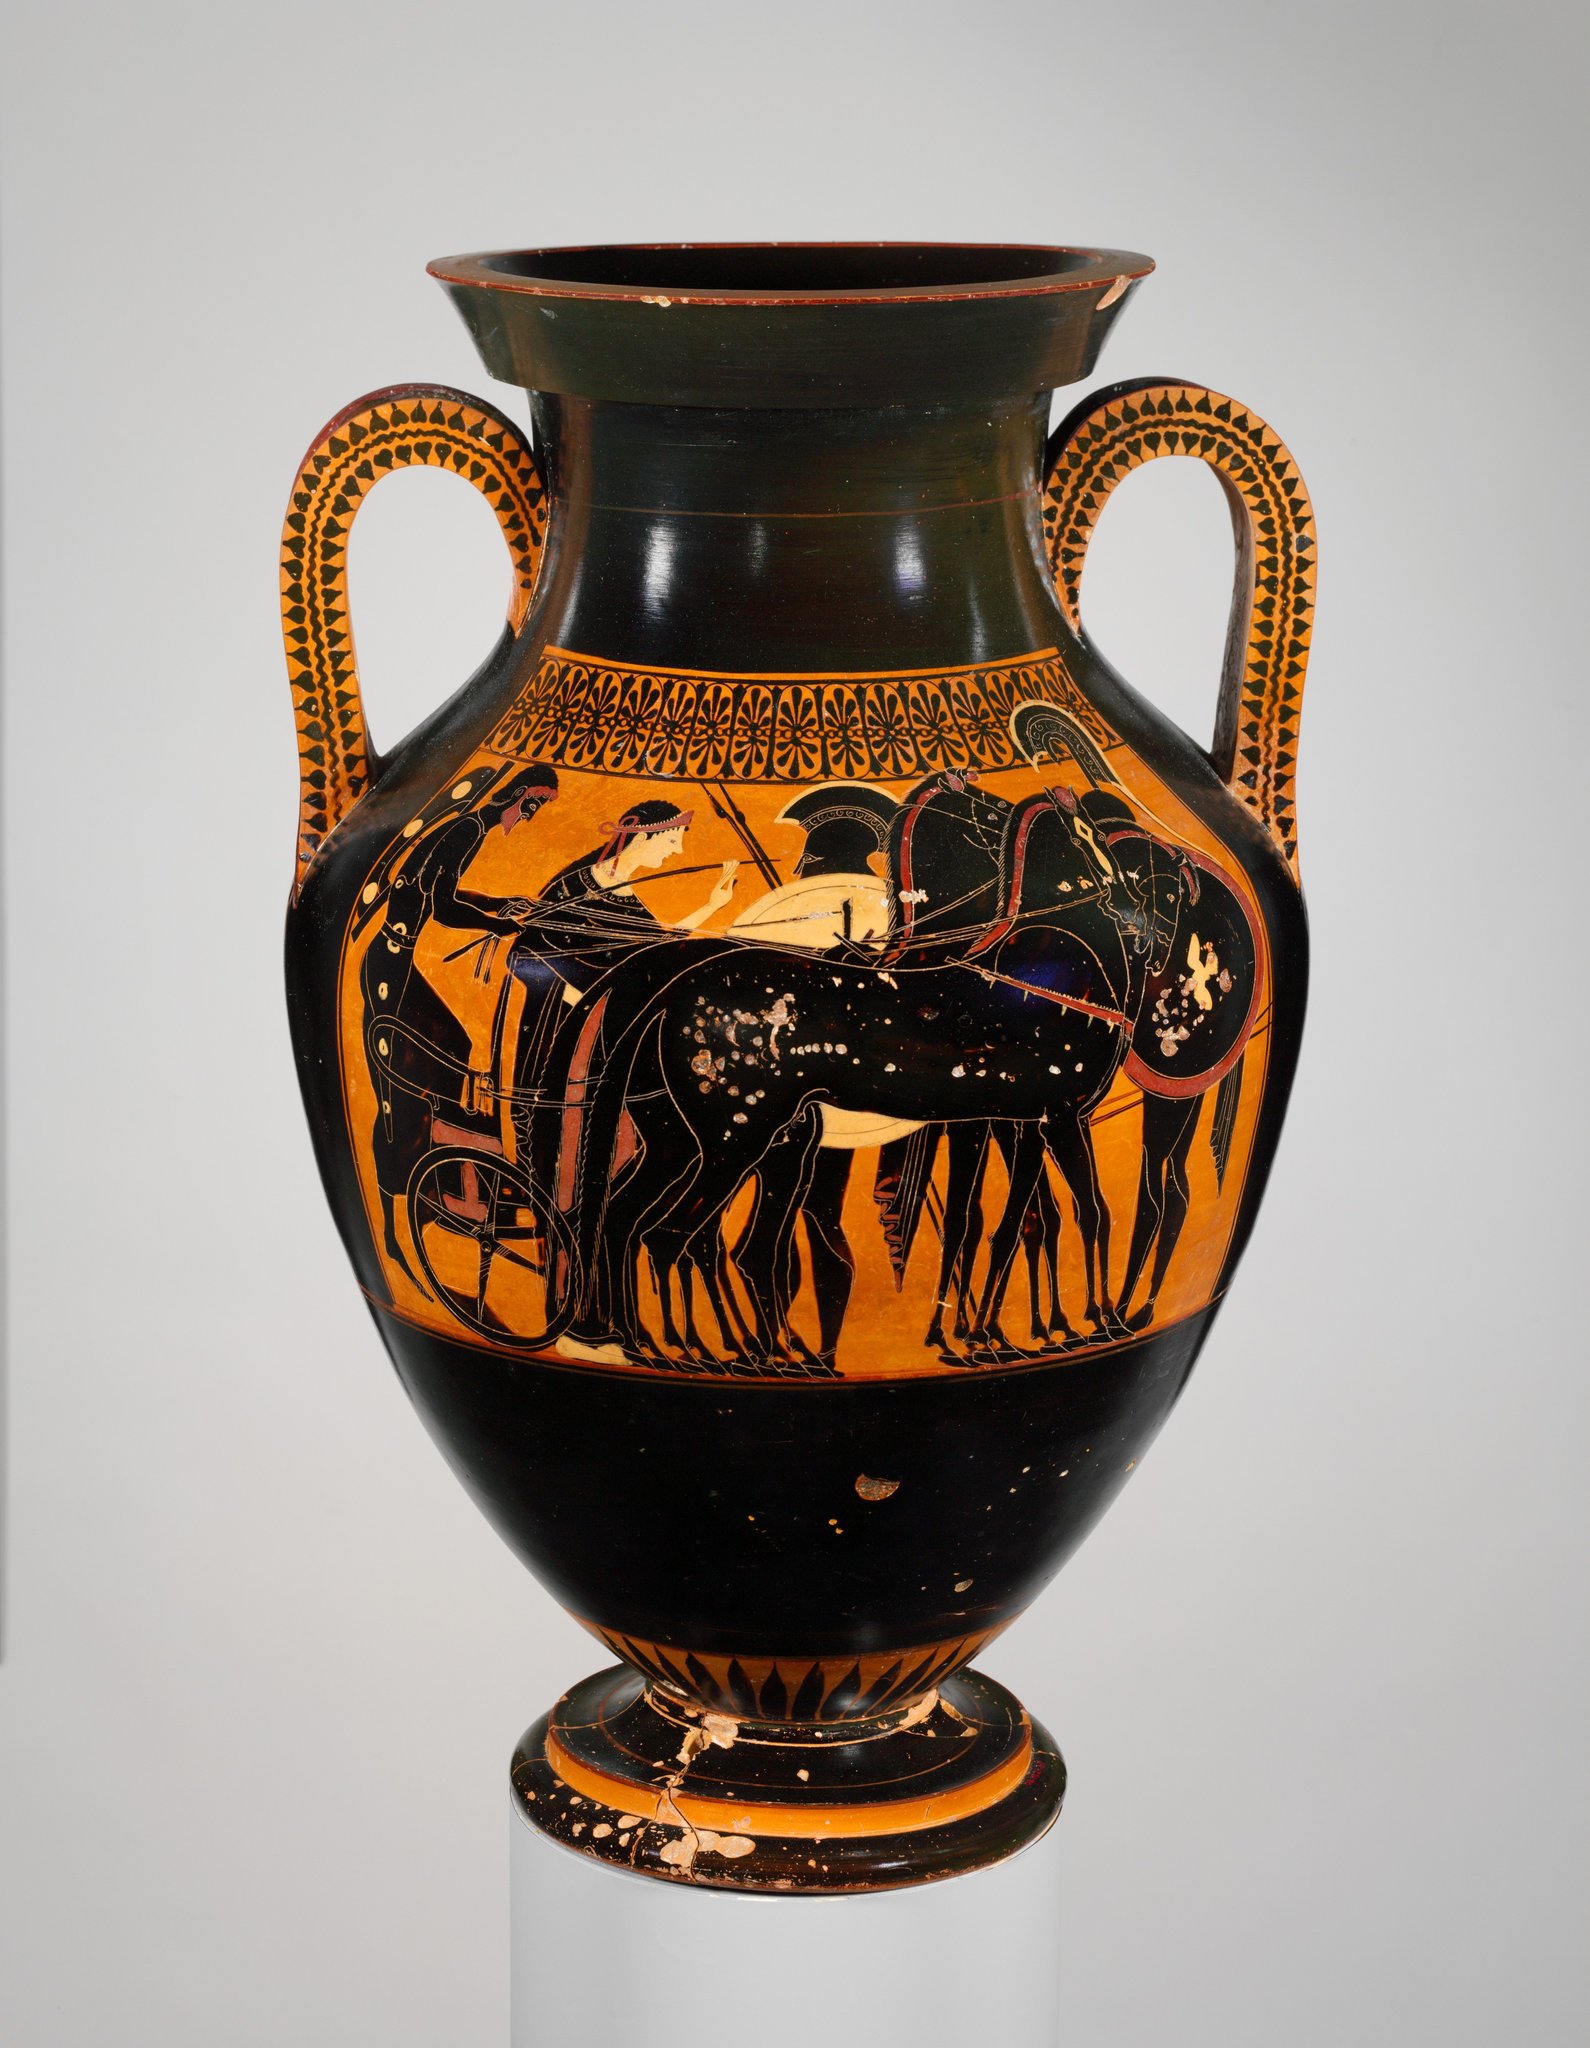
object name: amphora, type a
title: Terracotta amphora (jar)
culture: greek, attic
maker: rycroft painter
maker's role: artist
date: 510 BCE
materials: terracotta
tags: horses,chariots